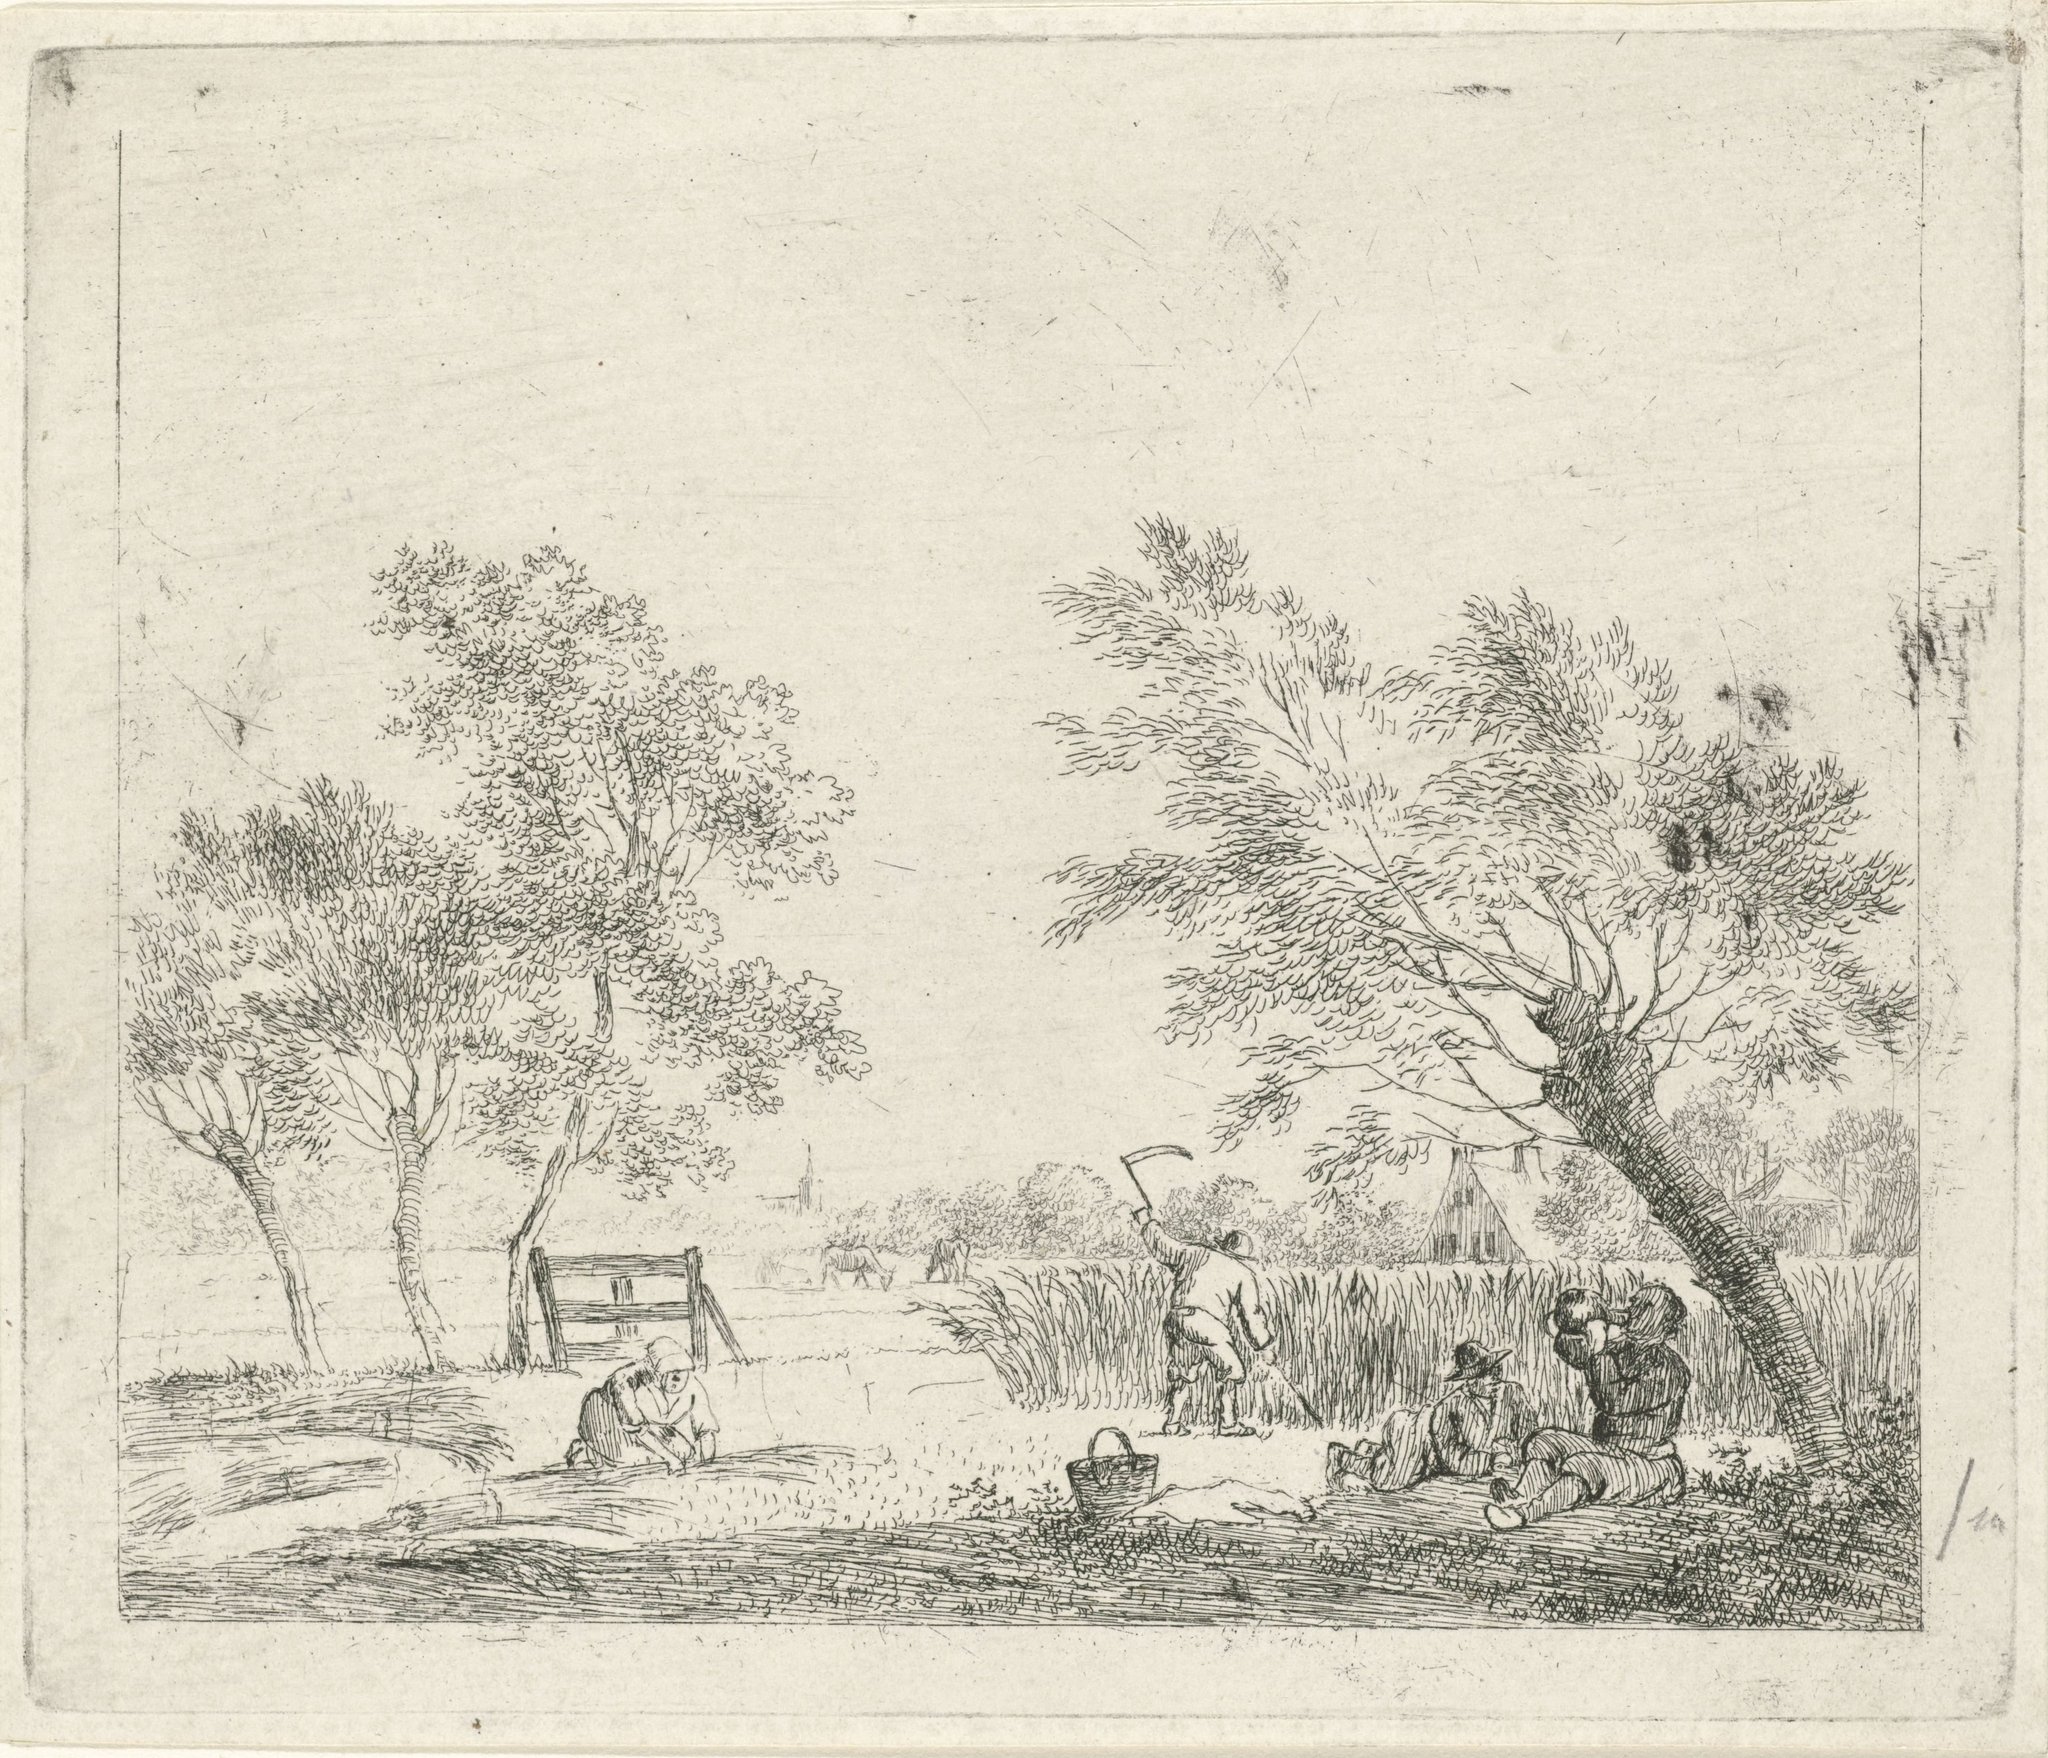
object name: print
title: De gecouleurde Teekeningen van de 12 Maanden (...)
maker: johannes janson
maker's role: draughtsman, painter, print maker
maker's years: 1729-1784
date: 1783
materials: paper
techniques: etching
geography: leiden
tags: harvest, landscape symbolizing august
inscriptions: collector's mark: Lugt 2228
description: Landschap met boerin die koren bijeen bindt en een boer die koren oogst. Rechts op de voorgrond twee mannen, zittend en liggend onder een boom. Vóór de lucht en vóór de man links op de achtergrond. Negende prent uit een serie van dertien met maanden.